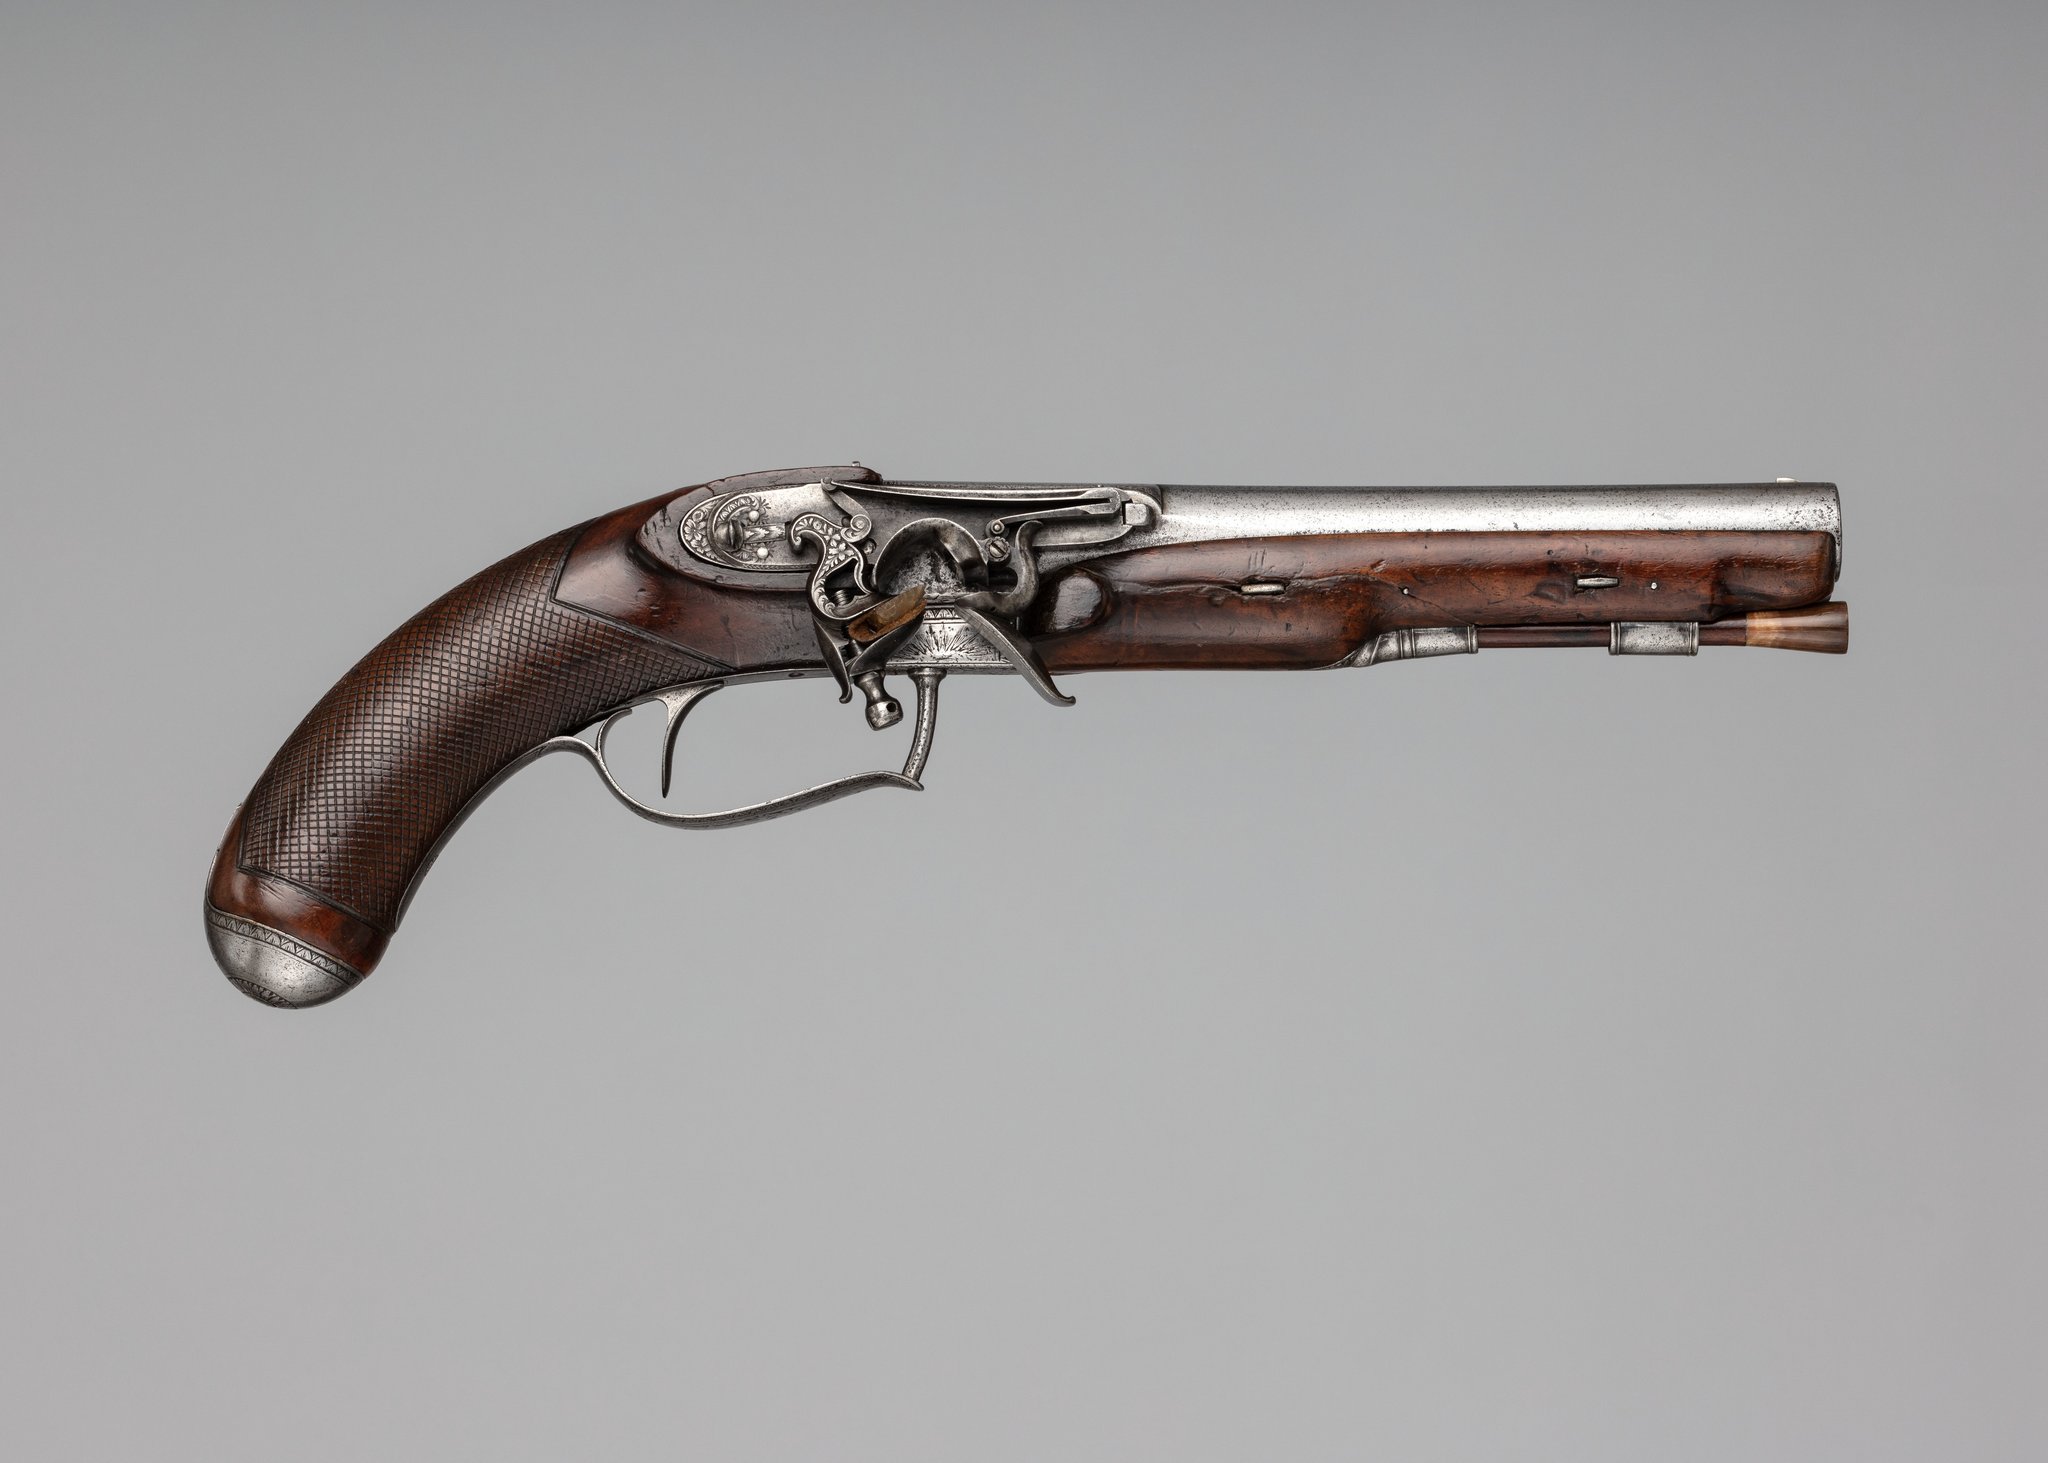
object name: flintlock pistol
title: Flintlock Pistol with Inverted Lock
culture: british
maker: joseph egg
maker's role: gunsmith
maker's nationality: british, born france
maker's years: 1775-1837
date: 1813-1814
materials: horn, steel, wood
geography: england